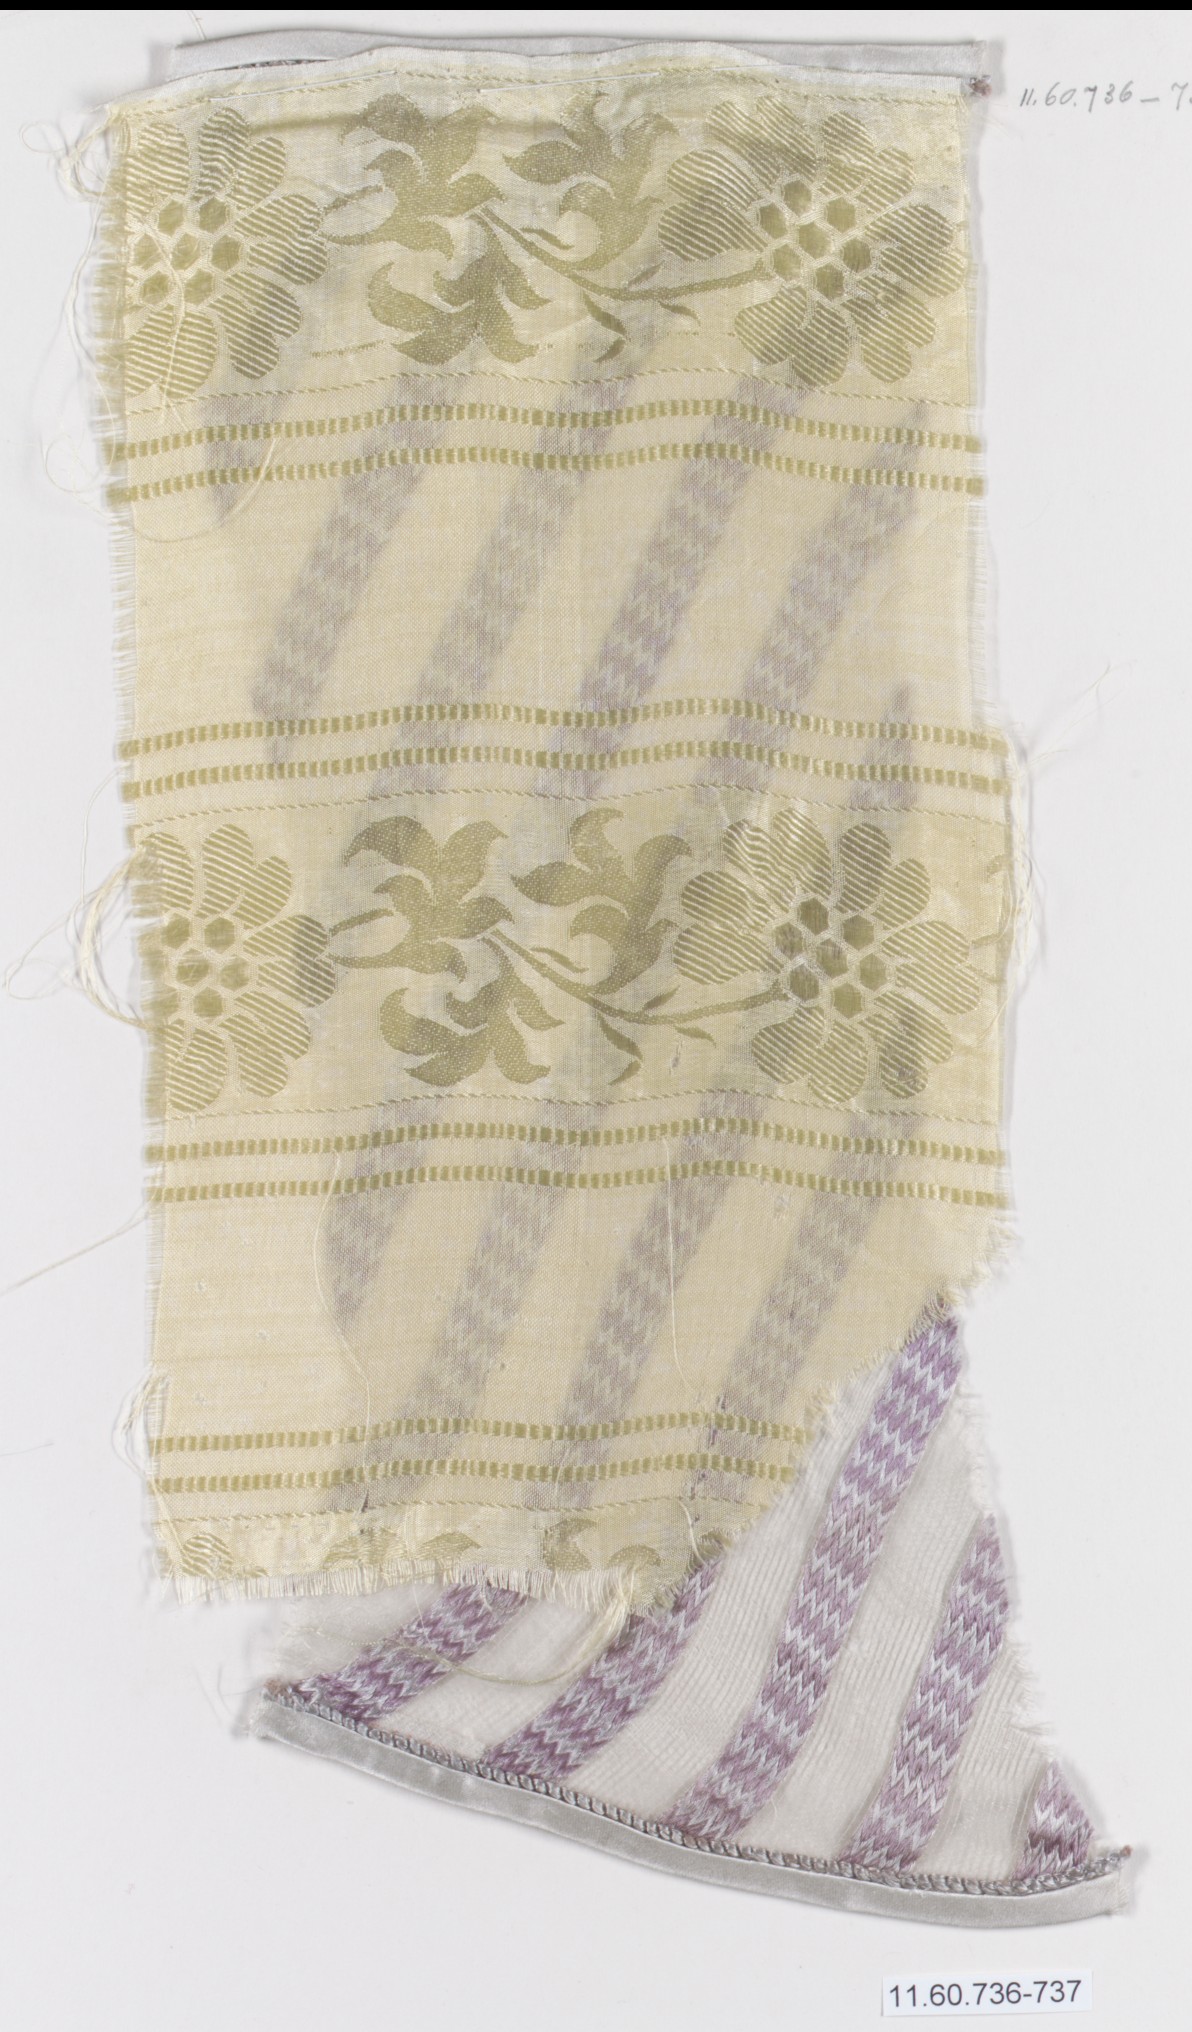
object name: sample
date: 1801-1850